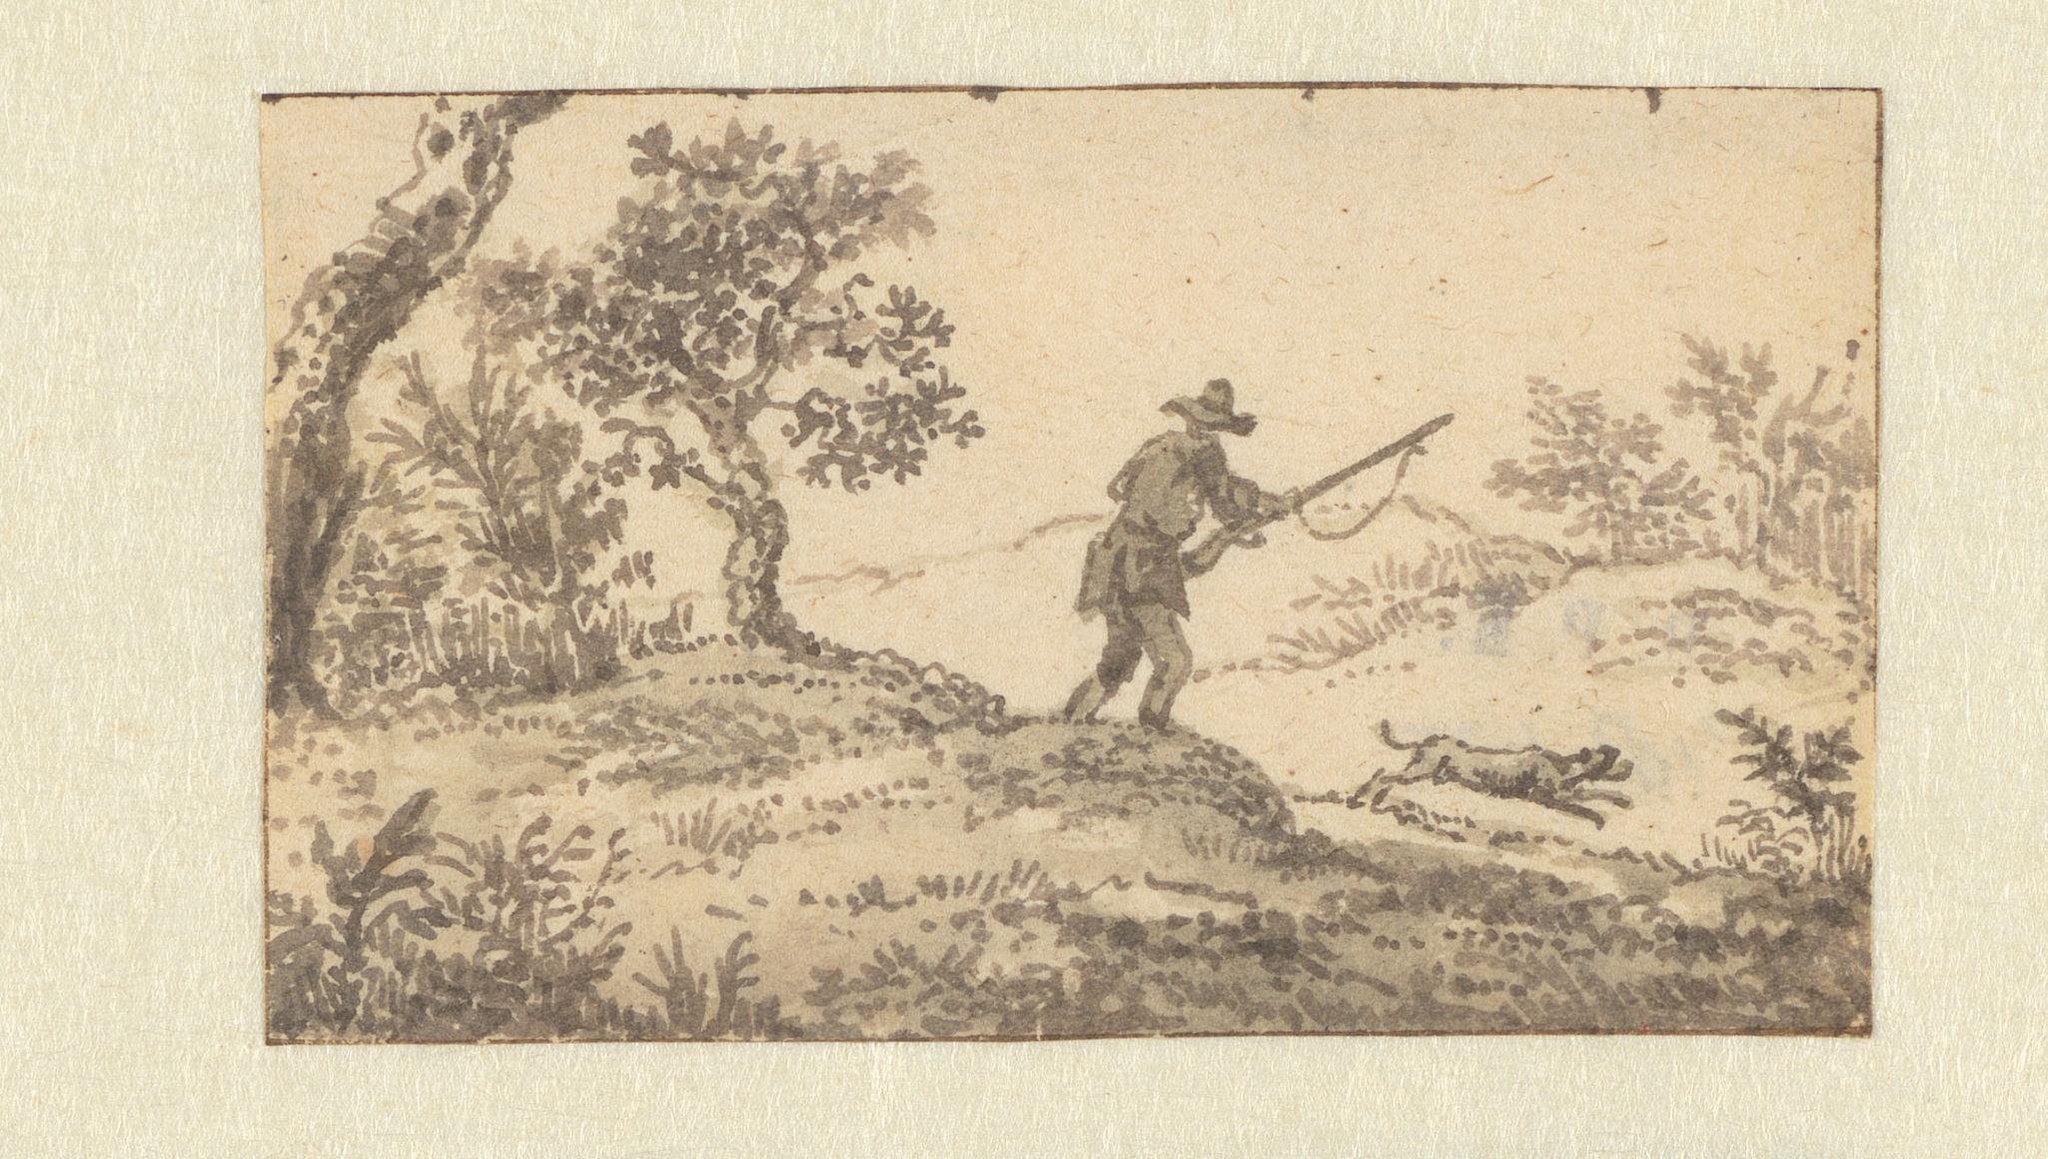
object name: drawing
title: Landschap met een jager en zijn hond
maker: aarnout ter himpel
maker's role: draughtsman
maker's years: 1634-1686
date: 1644-1686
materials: paper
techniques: brush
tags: hunter (+ hunting with dogs)